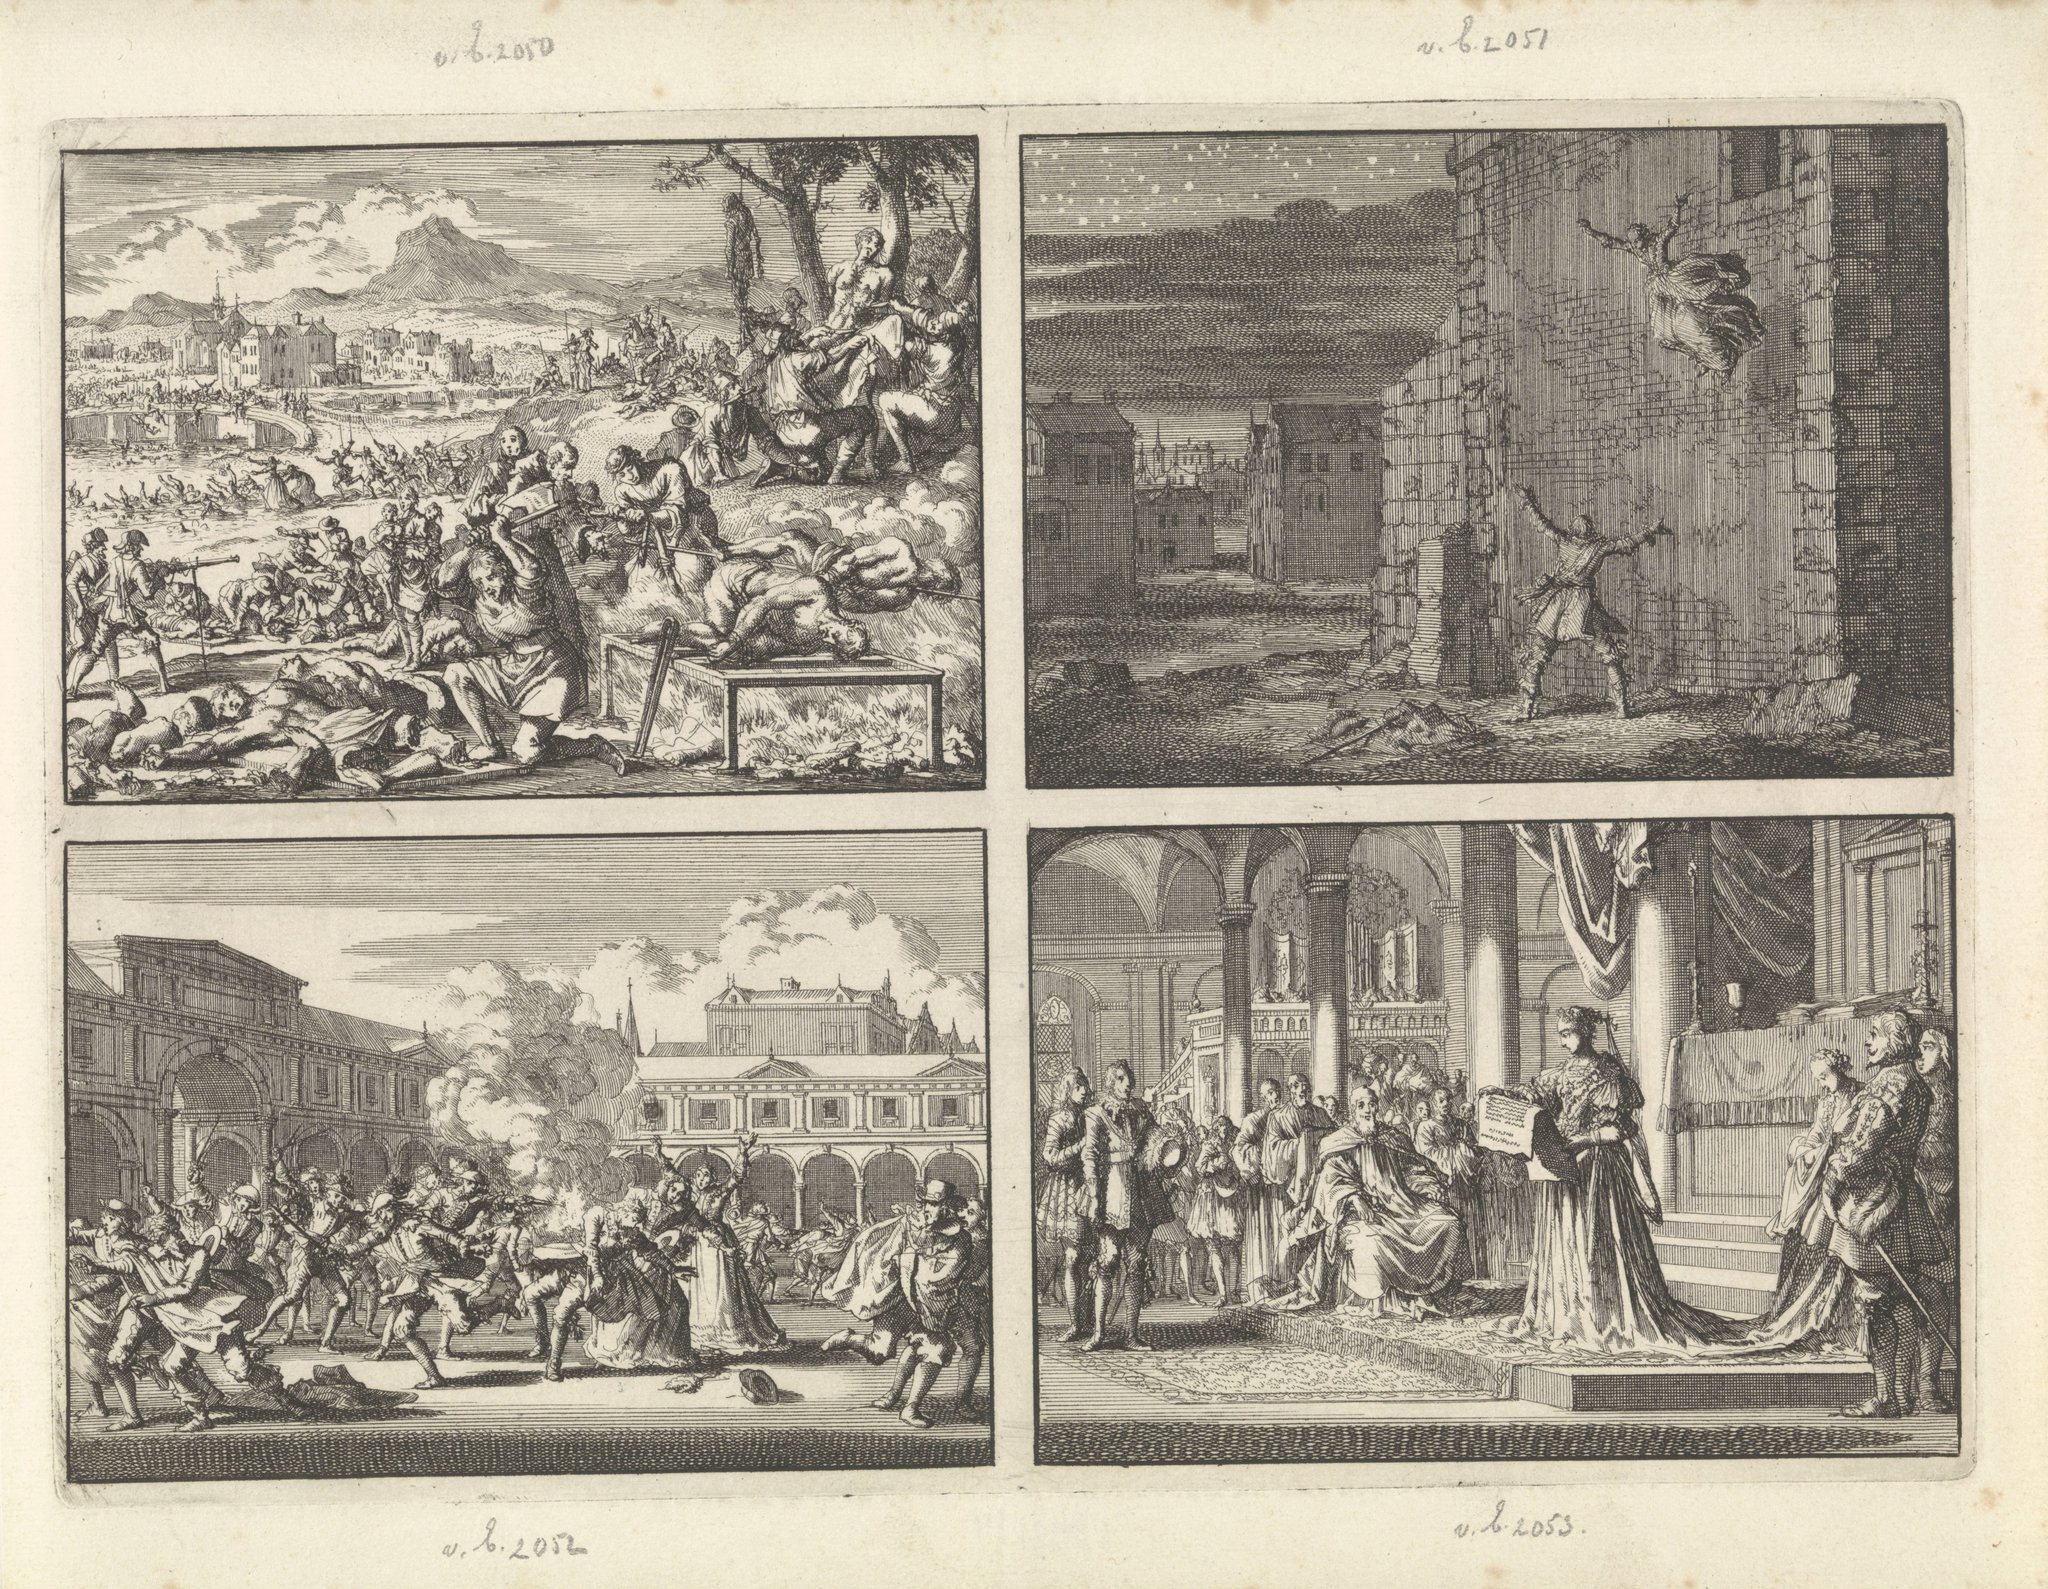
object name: print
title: Vervolging van protestanten in Ierland, 1641 / Gravin van Aubigny ontsnapt uit haar gevangenis in Londen door uit het venster te springen, 1643 / Mannen uit het gevolg van de Portugese gezant te Londen schieten op de beurs Harcourt Greenway overhoop, 1653 / Kerk te Innsbrück waar Christina van Zweden haar verklaring van haar overgang naar de katholieke kerk voorleest, 1655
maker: jan luyken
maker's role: draughtsman, print maker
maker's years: 1649-1712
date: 1698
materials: paper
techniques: etching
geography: amsterdam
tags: rome, christina (koningin van zweden), london, escape, escape attempts, roman catholic church, interior of church, violent death, being killed; being mishandled and maltreated; seeking death, persecution of heretics, attempt, political murder, night, conversion and belief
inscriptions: collector's mark: Lugt 2228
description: Prenten gebruikt als illustratie in: Gottfried, Johann Ludwig. Historische kronyck; vervattende een (...) beschrijvingh der aldergedenckwaerdigste geschiedenissen des weerelds, van den aenvangh der scheppingh tot (...) 1576 (2 delen). Leiden: Pieter van der Aa, 1698, dl. II, p. 293, 309, 339, 371.